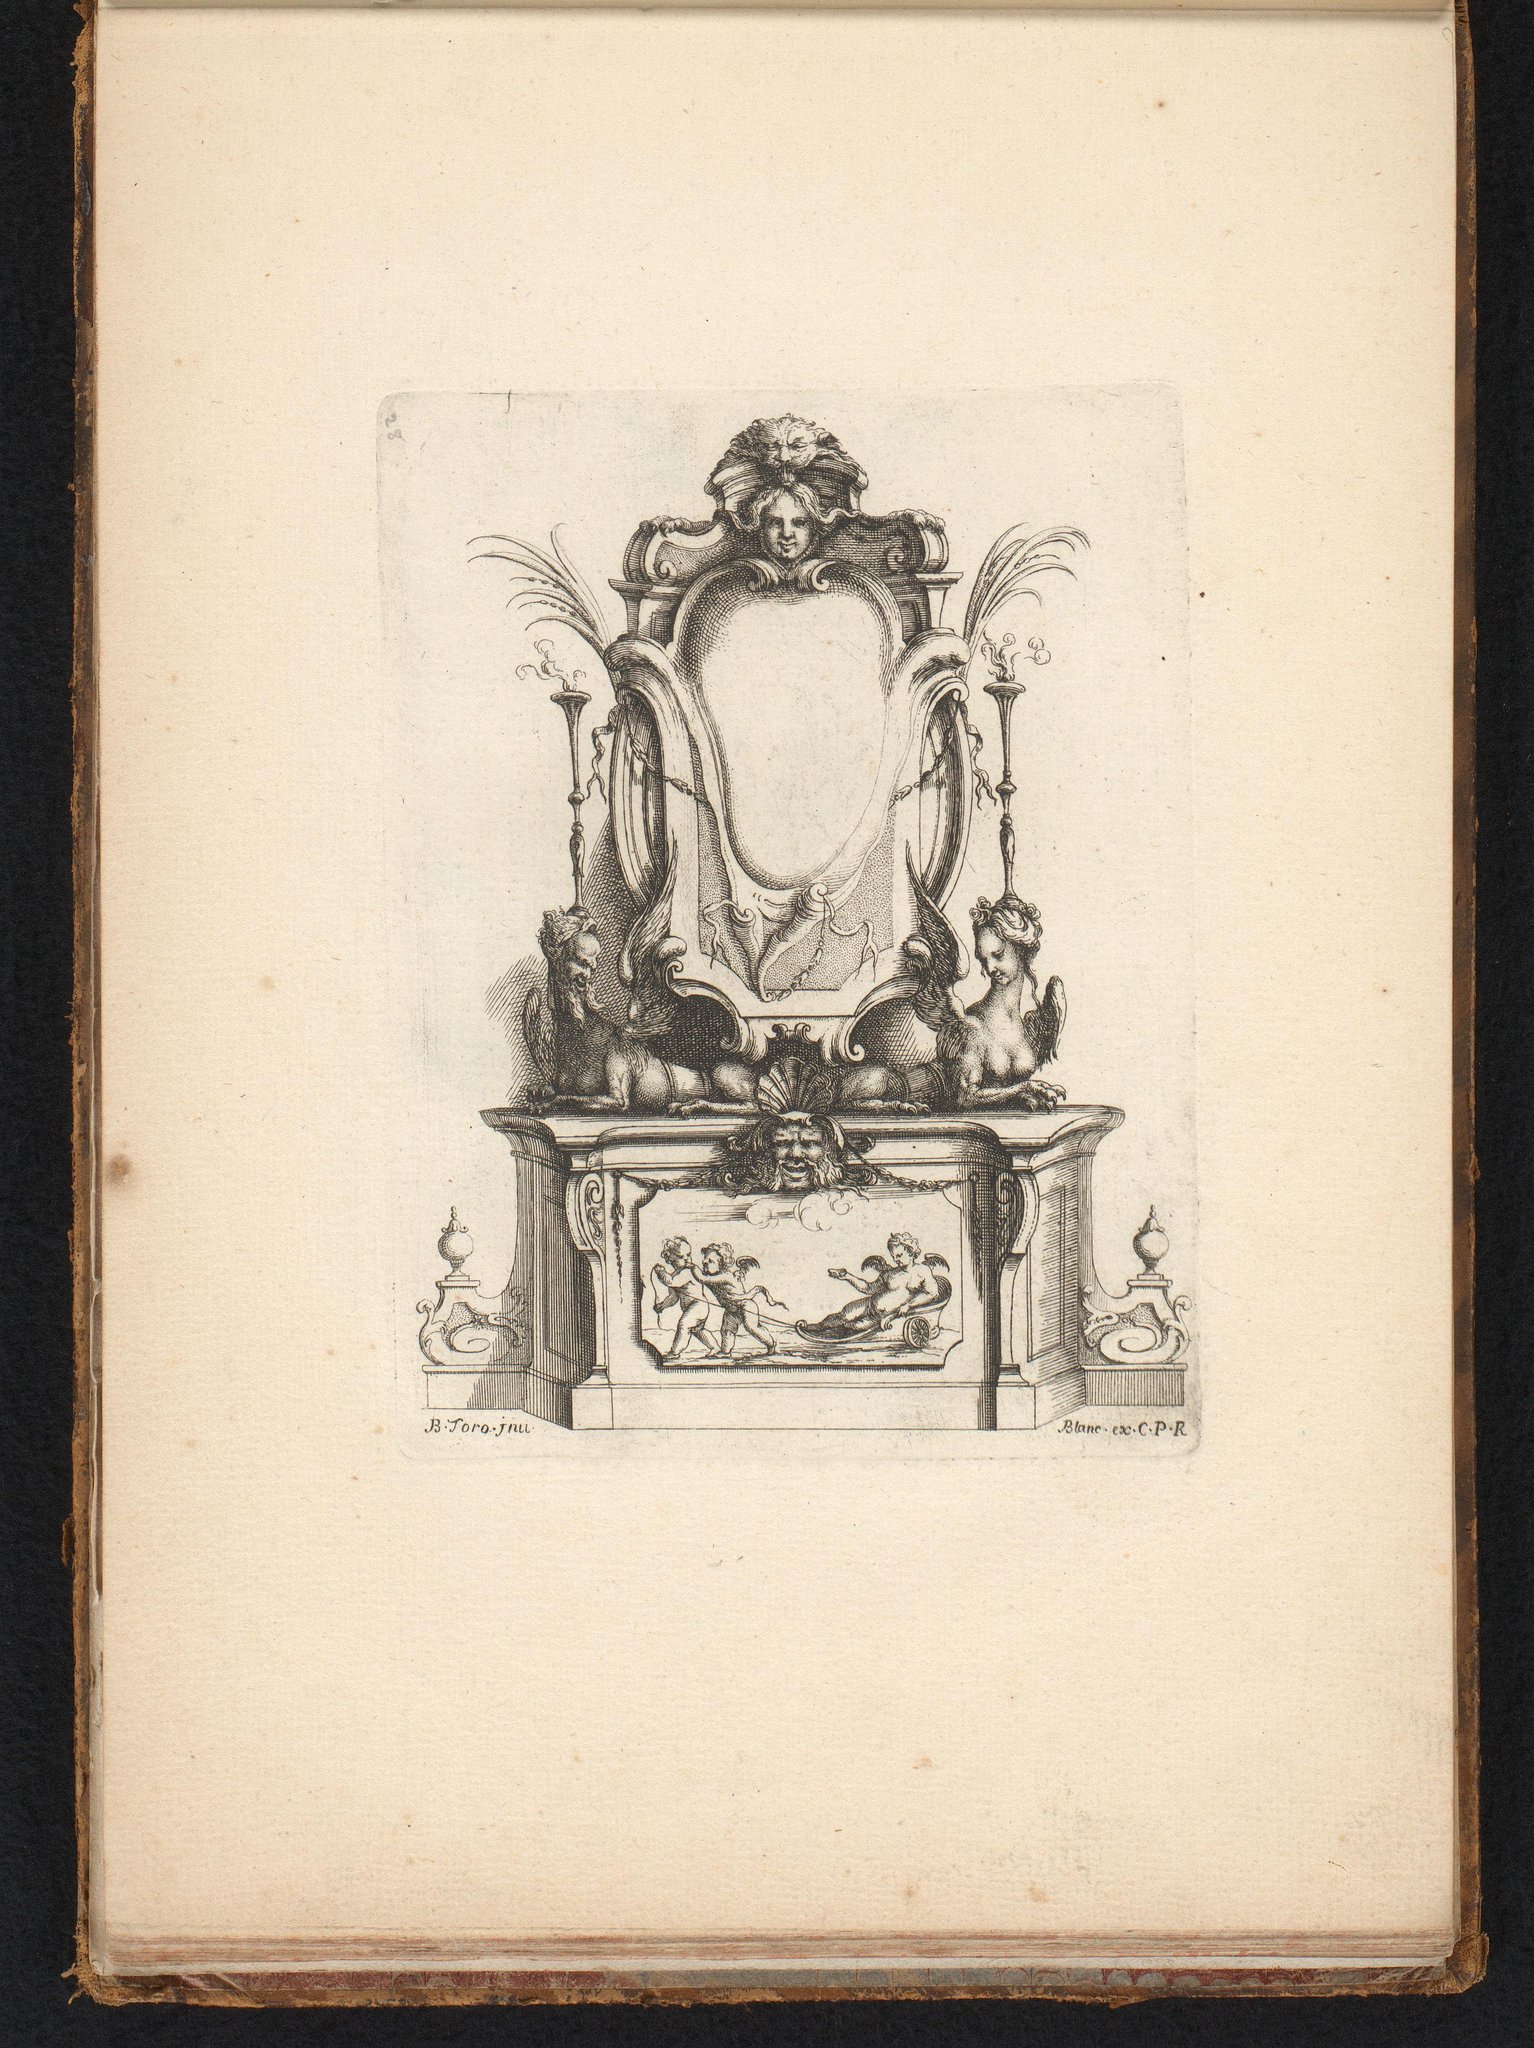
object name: album leaf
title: Ontwerpen voor cartouches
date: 1682-1729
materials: paper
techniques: engraving, etching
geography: france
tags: ornament ~ cartouche, cupids: 'amores', 'amoretti', 'putti', monsters ~ predatory animals (sphinx, 'manticora')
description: Prent maakt deel uit van een serie van zes prenten.